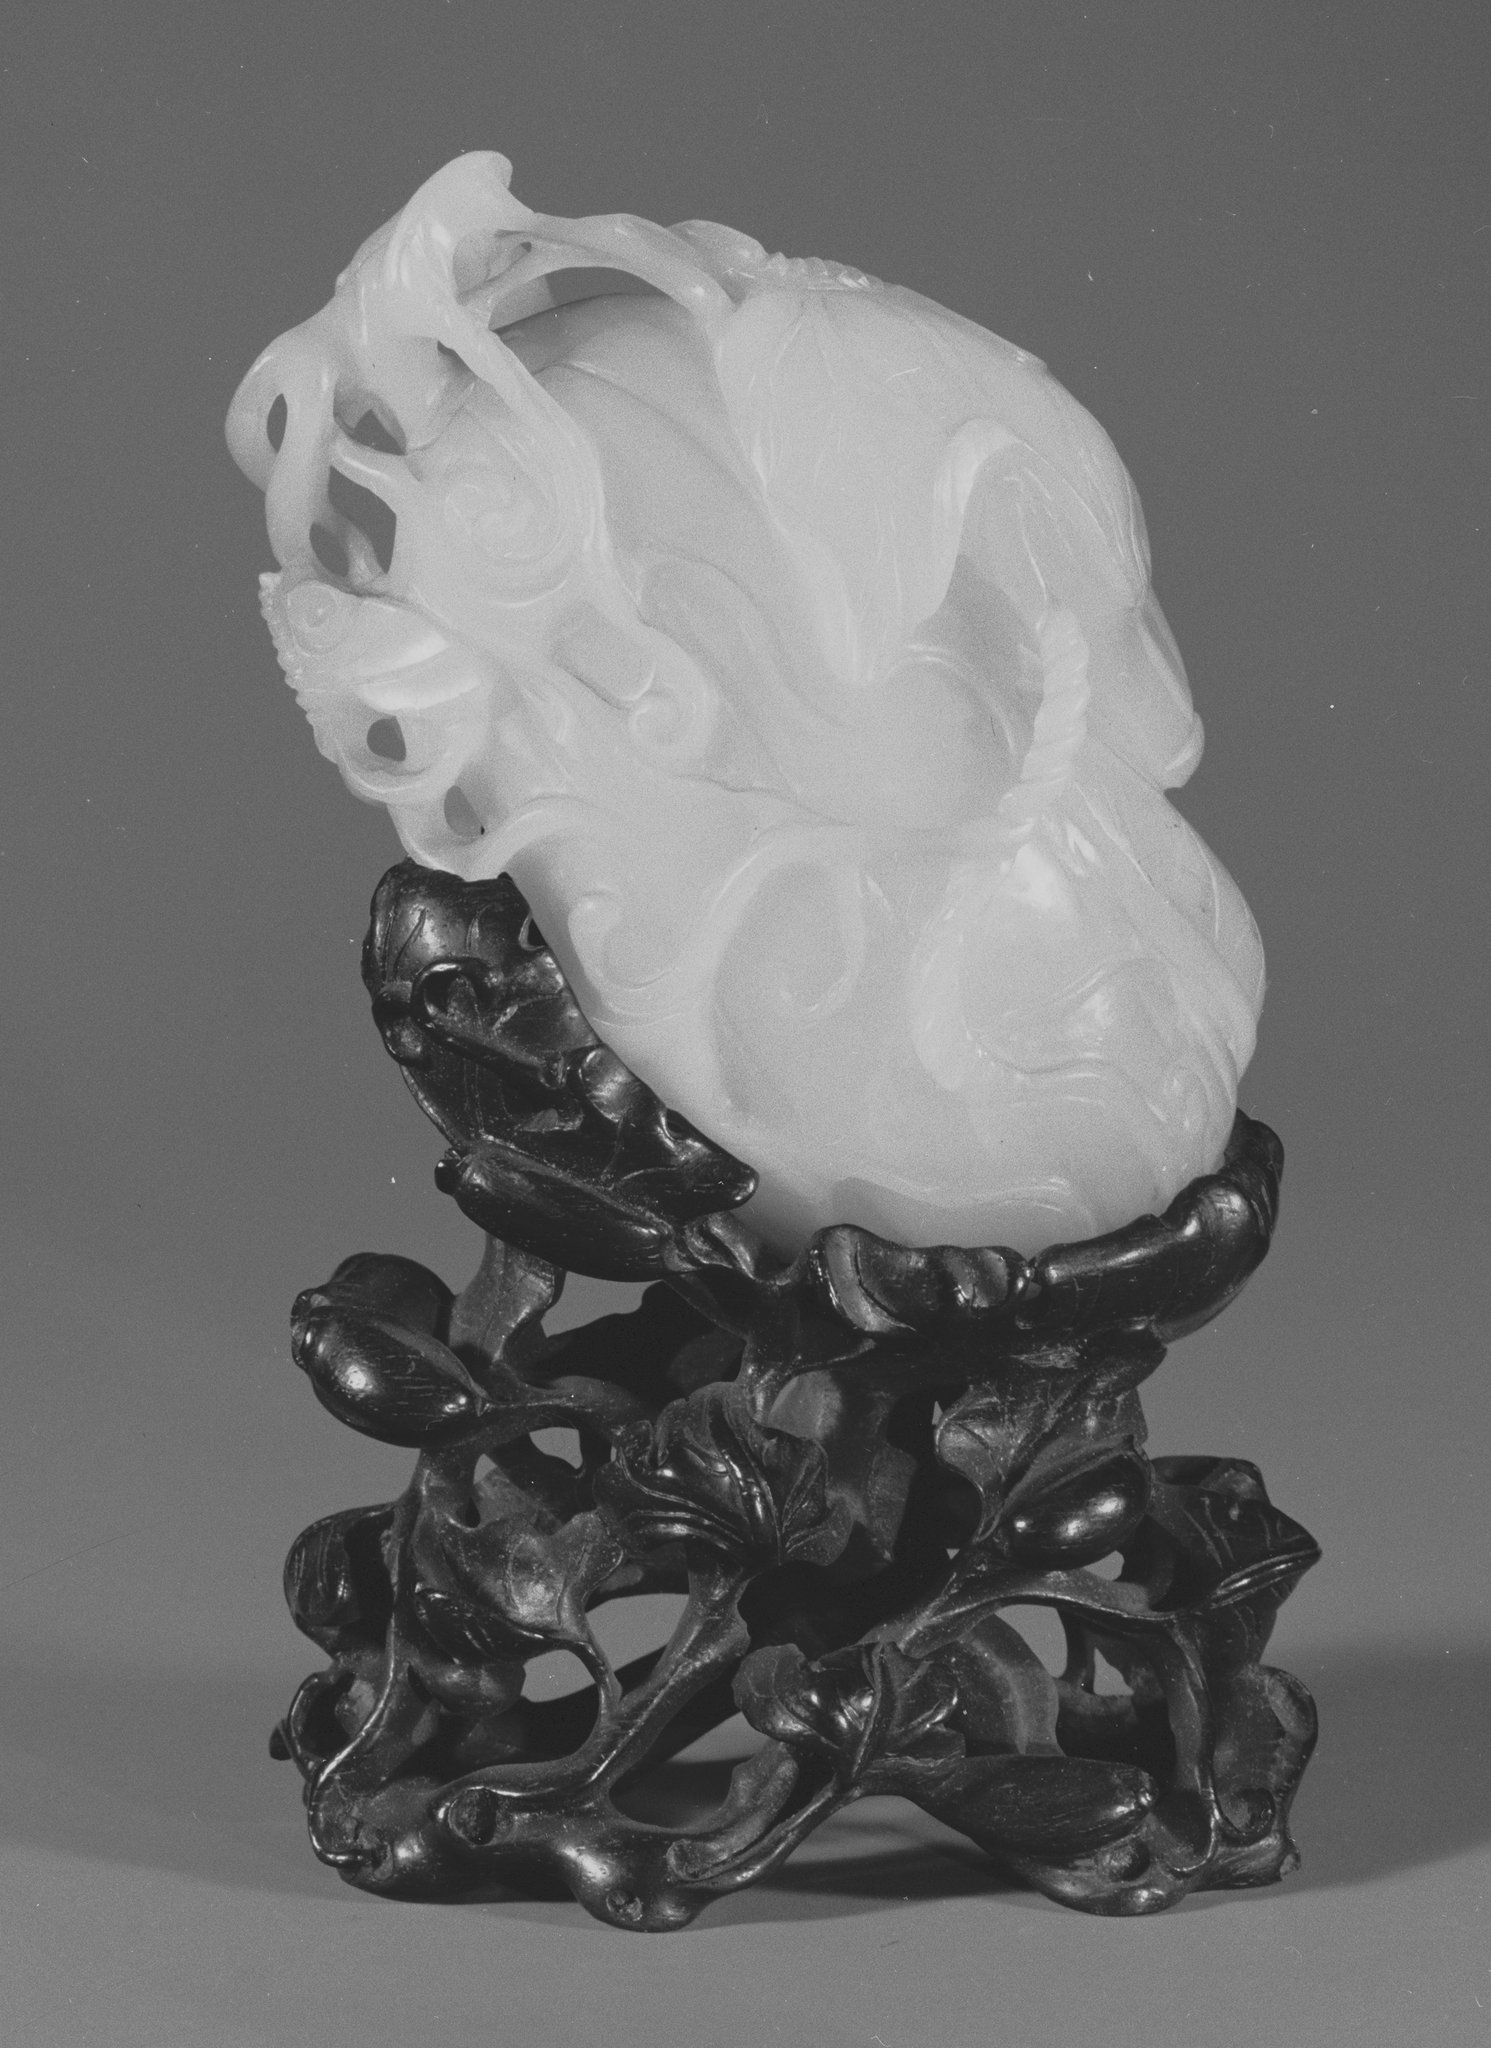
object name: paperweight on stand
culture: chinese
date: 1701-1800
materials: jade